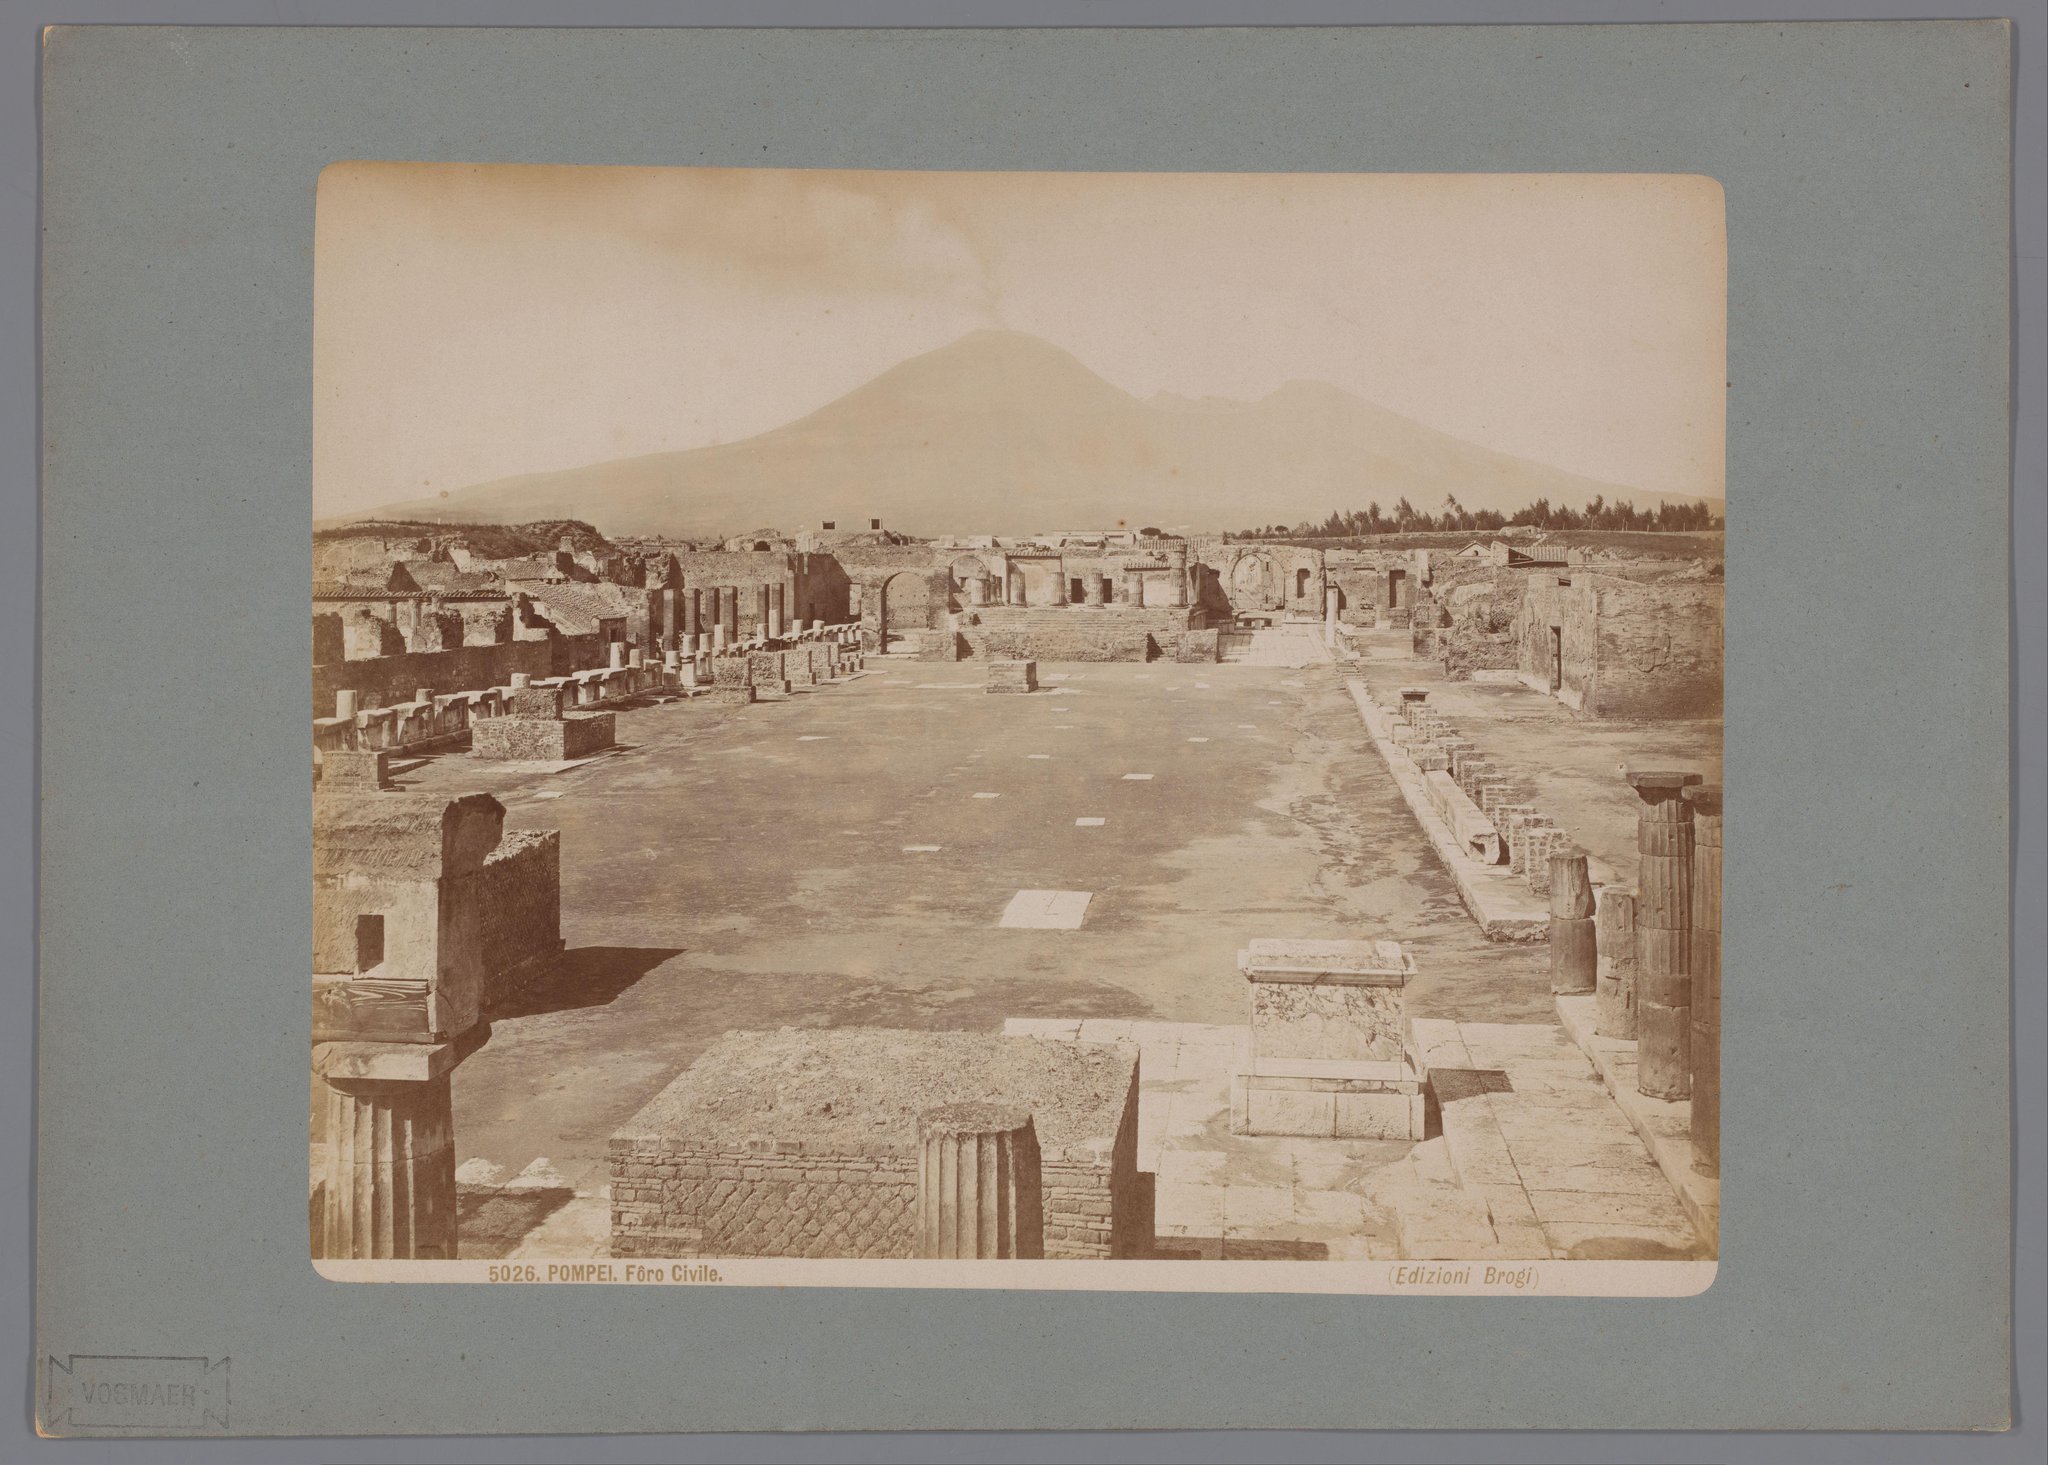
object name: photograph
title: Pompei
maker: giacomo brogi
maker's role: fotograaf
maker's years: 1822-1881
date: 1864-1881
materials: cardboard, paper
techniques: albumen print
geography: florence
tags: square, place, circus, etc., ruin of a building ~ architecture, landscape with ruins, volcano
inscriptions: inscription: ‘doubl’, collector's mark: ‘VOSMAER’, number: ‘5026.’